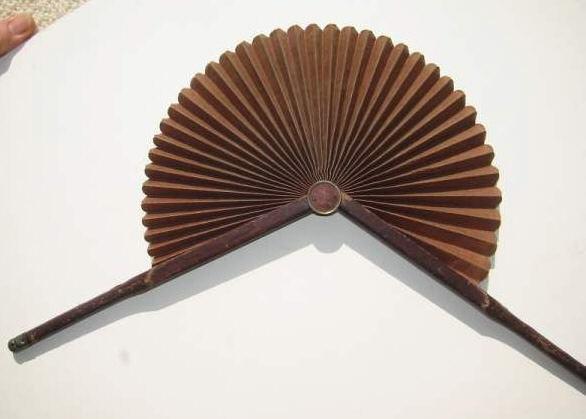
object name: fan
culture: american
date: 1767-1833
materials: leather, metal, paper, wood